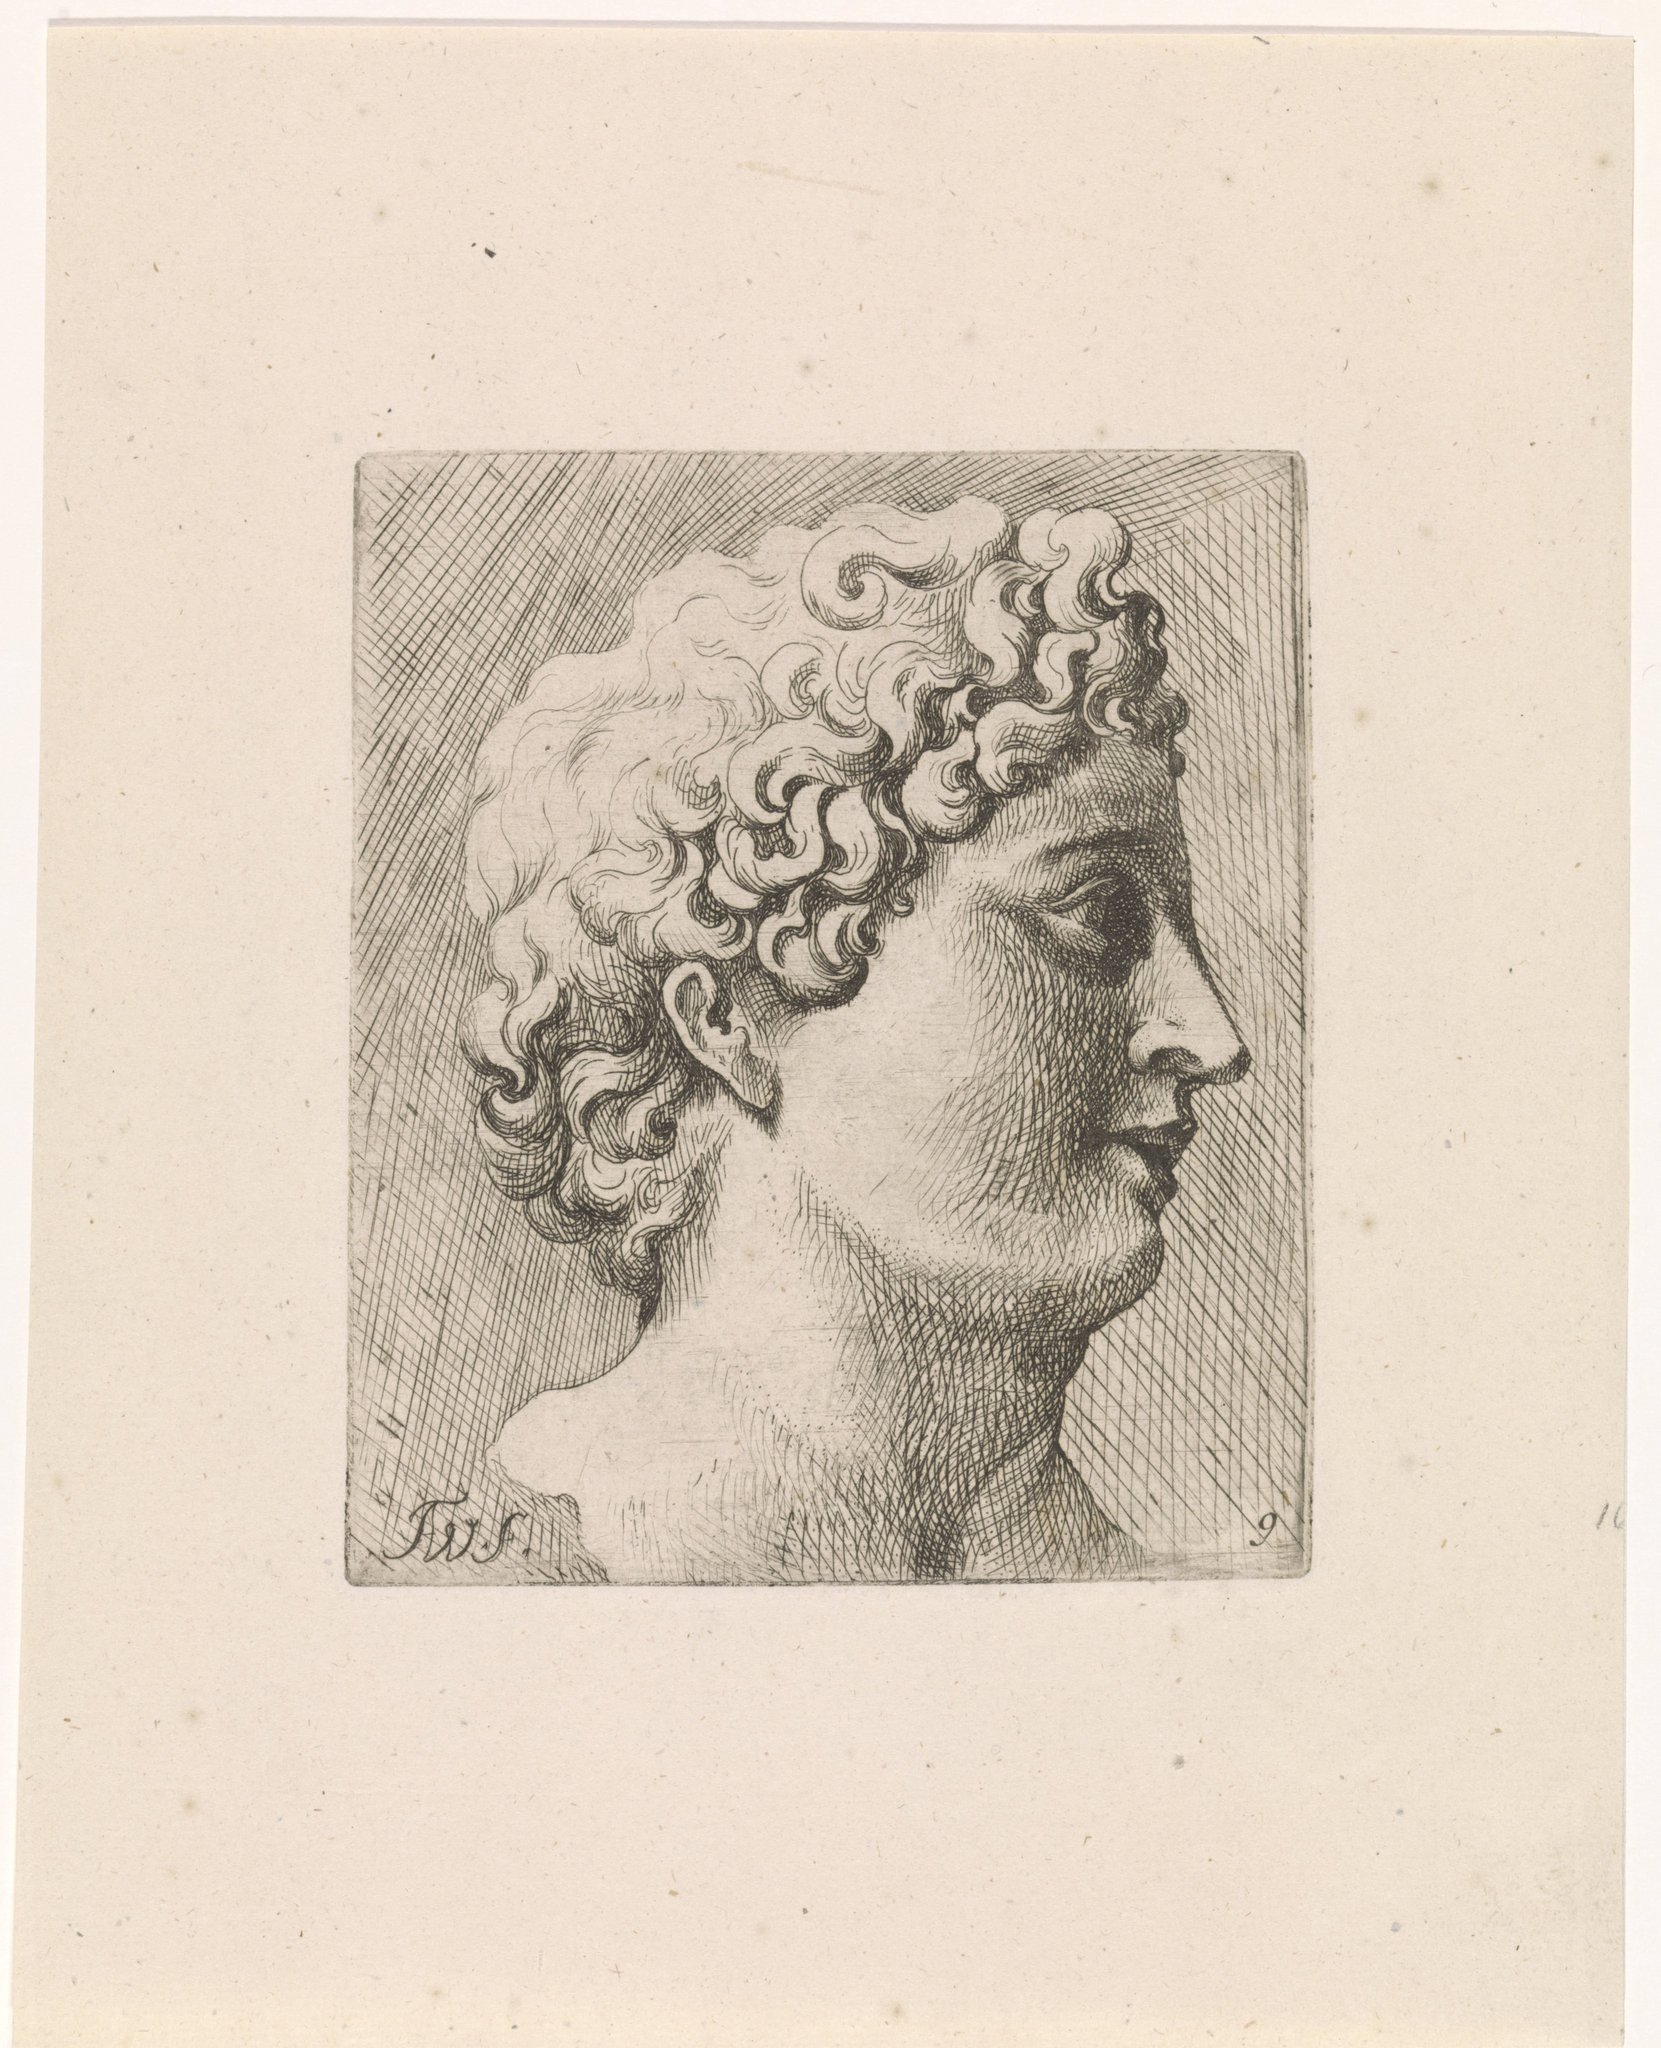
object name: print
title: Studies voor een tekeningenboek naar klassieke sculpturen en figuren van Anthony van Dyck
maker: augustinus terwesten (i)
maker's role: draughtsman, painter, print maker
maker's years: 1649-1711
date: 1672-1711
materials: paper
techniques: etching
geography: rome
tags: piece of sculpture, reproduction of a piece of sculpture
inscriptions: collector's mark: Lugt 2228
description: Hoofd van een jongeman naar rechts. Naar een klassieke sculptuur.